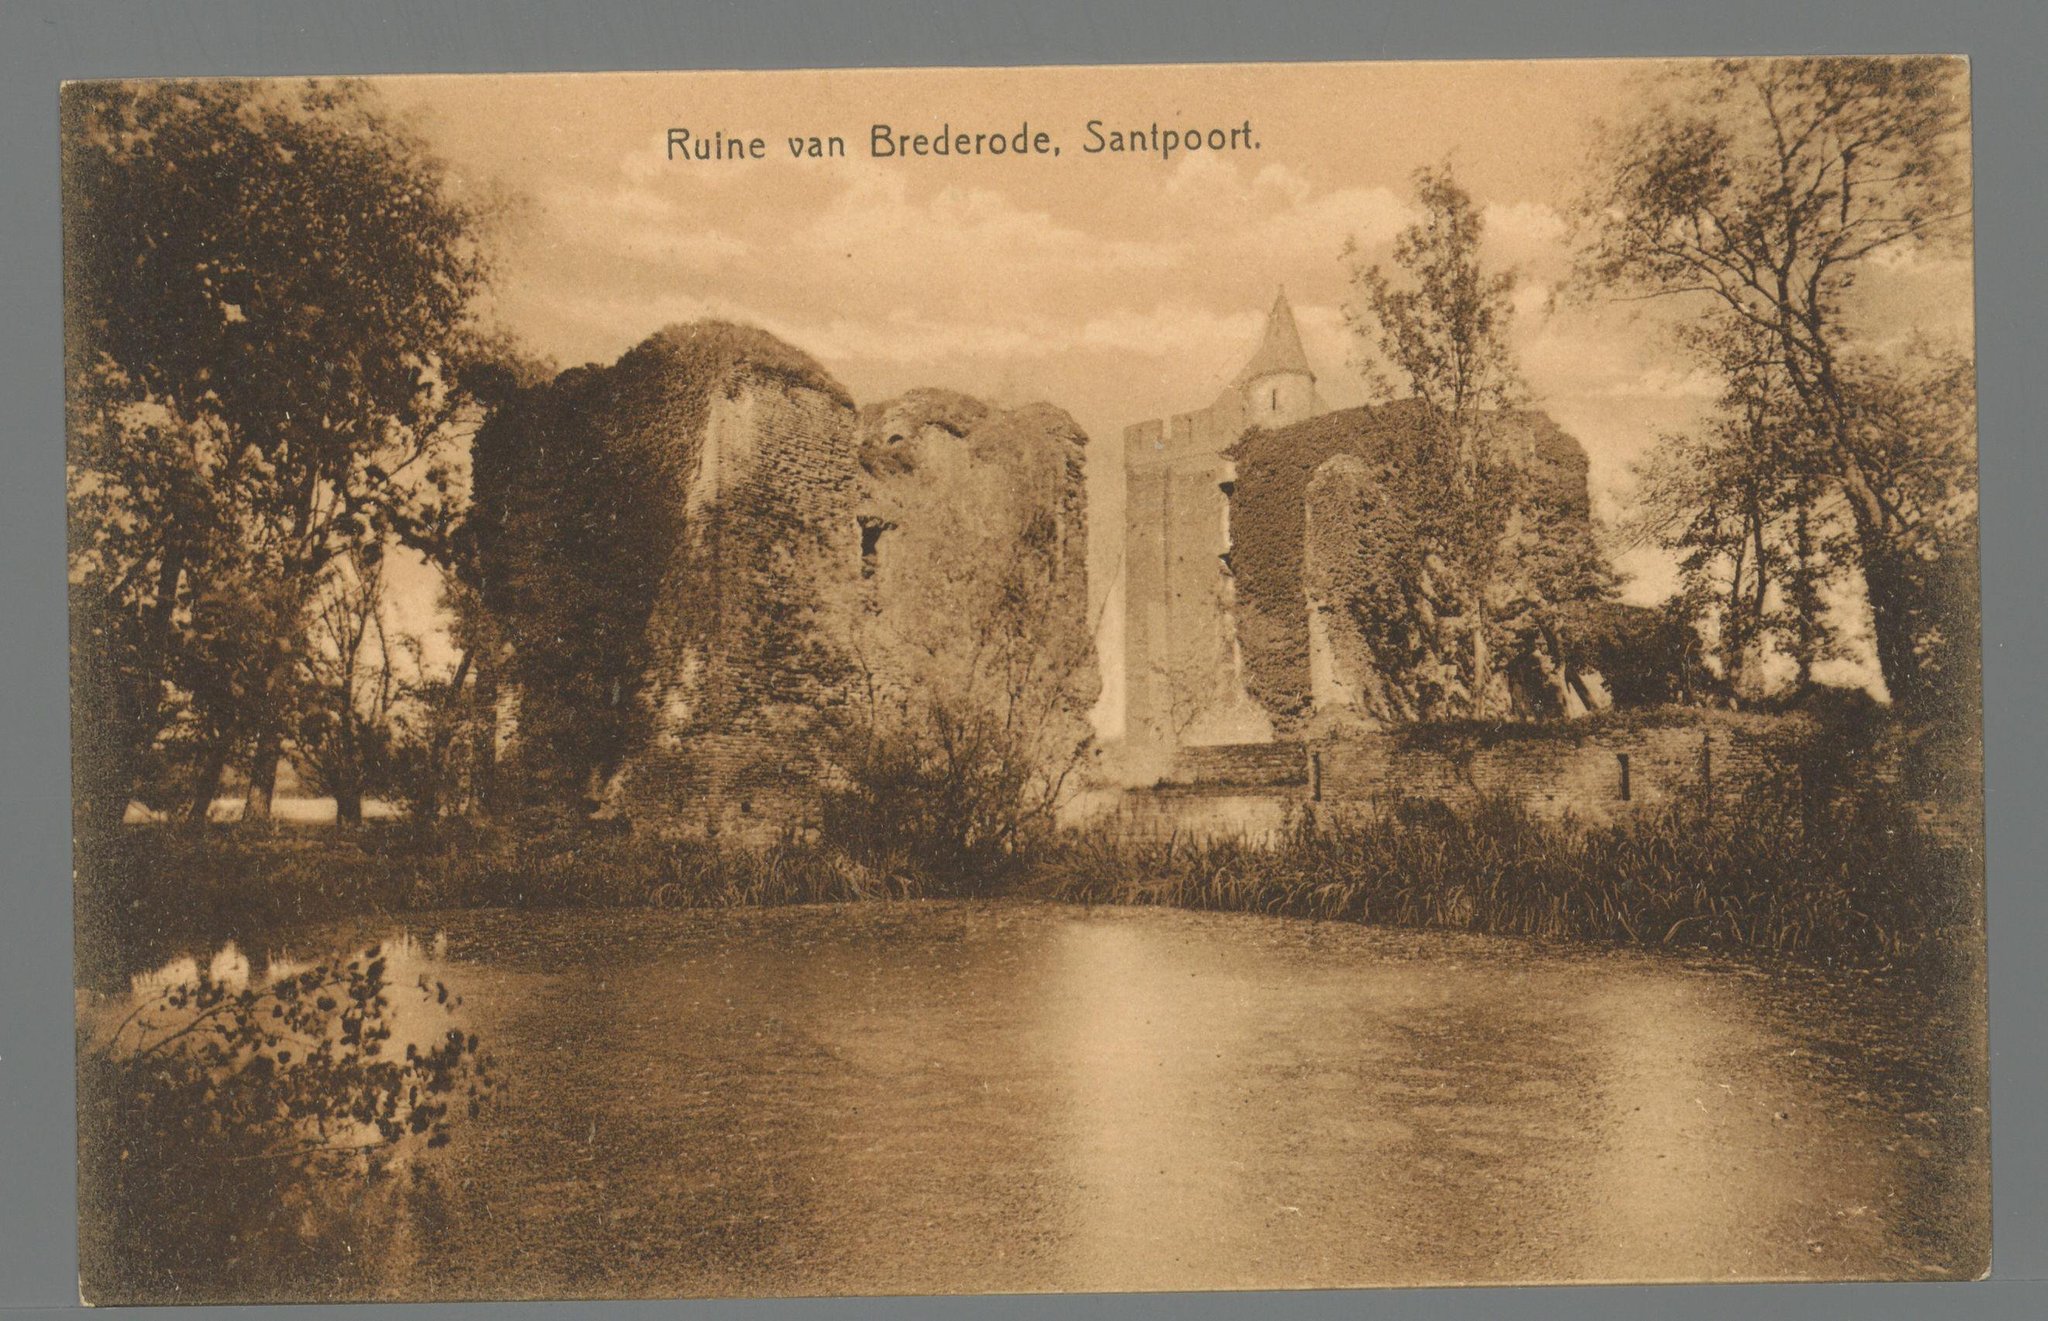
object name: ansichtkaart, prentbriefkaart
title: Ruine van Brederode, Santpoort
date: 1906-1910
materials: cardboard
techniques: photograph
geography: hamburg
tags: castle